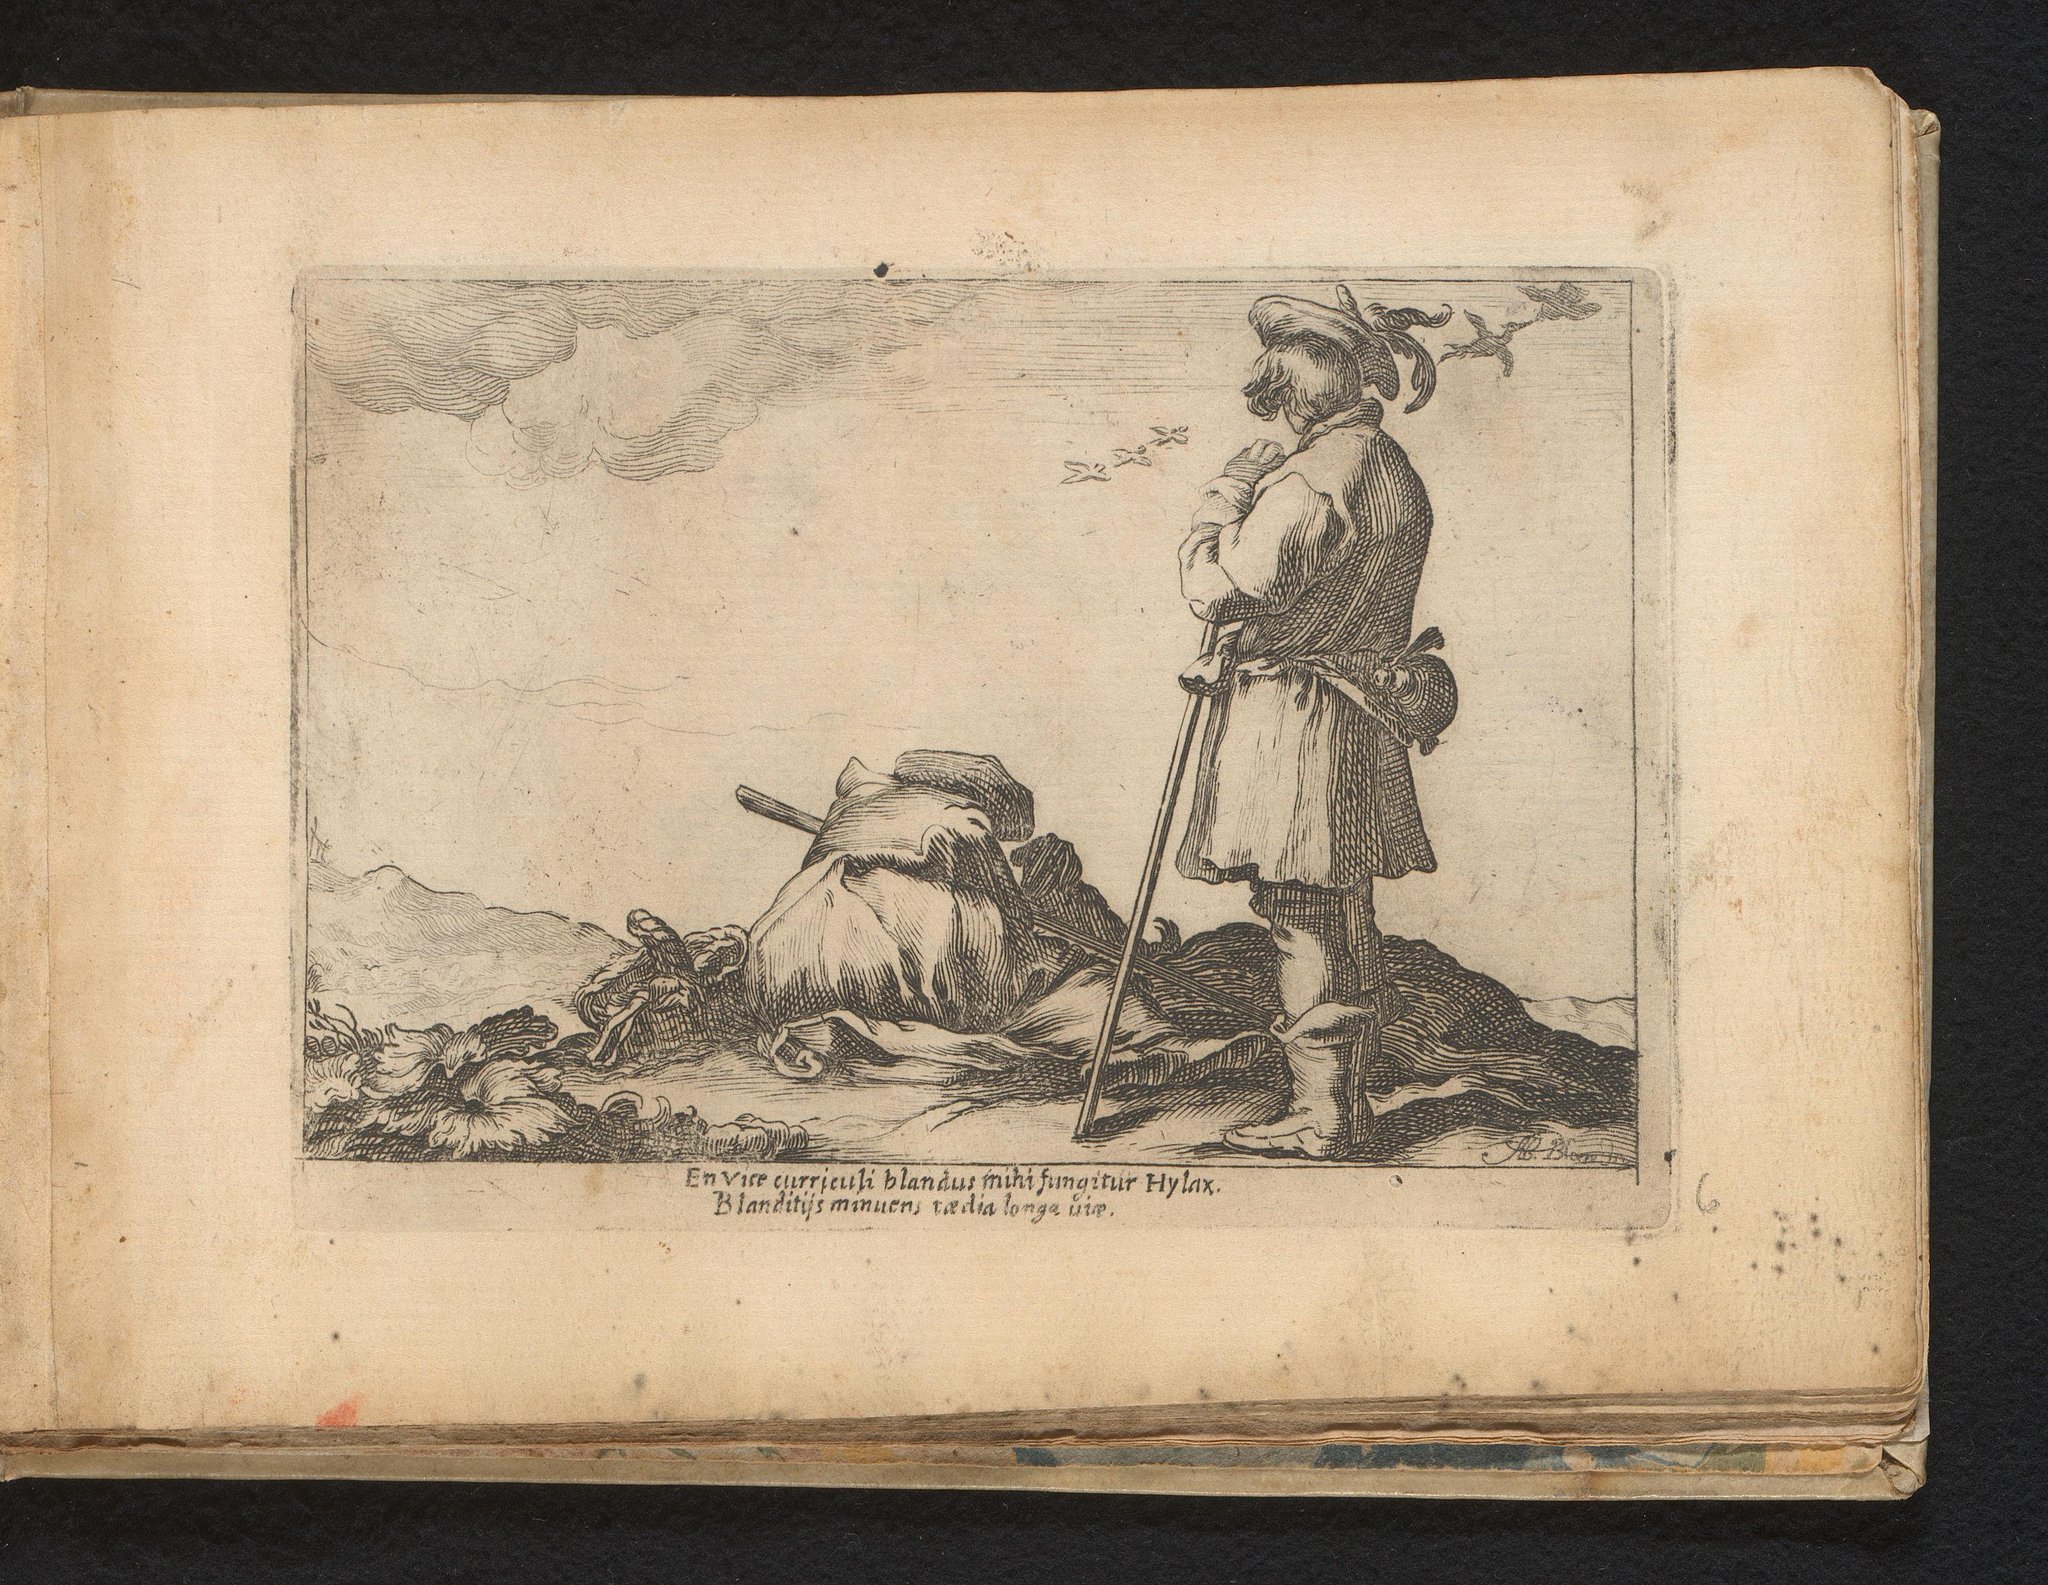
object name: print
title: Twee jongens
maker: Anonymous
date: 1629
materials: ink, paper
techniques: engraving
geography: utrecht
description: Een jongen bekijkt het uitzicht, een andere jongen ligt naast hem op de grond. Met tweeregelig vers in het Latijn in ondermarge. Het betreft de serie getiteld: Otia delectant faciuntq [...]. Kalfsleren band met opschrift en decoratieve kaderlijnen in pen in bruin. Voorin en achterin vier schutbladen van velijn.